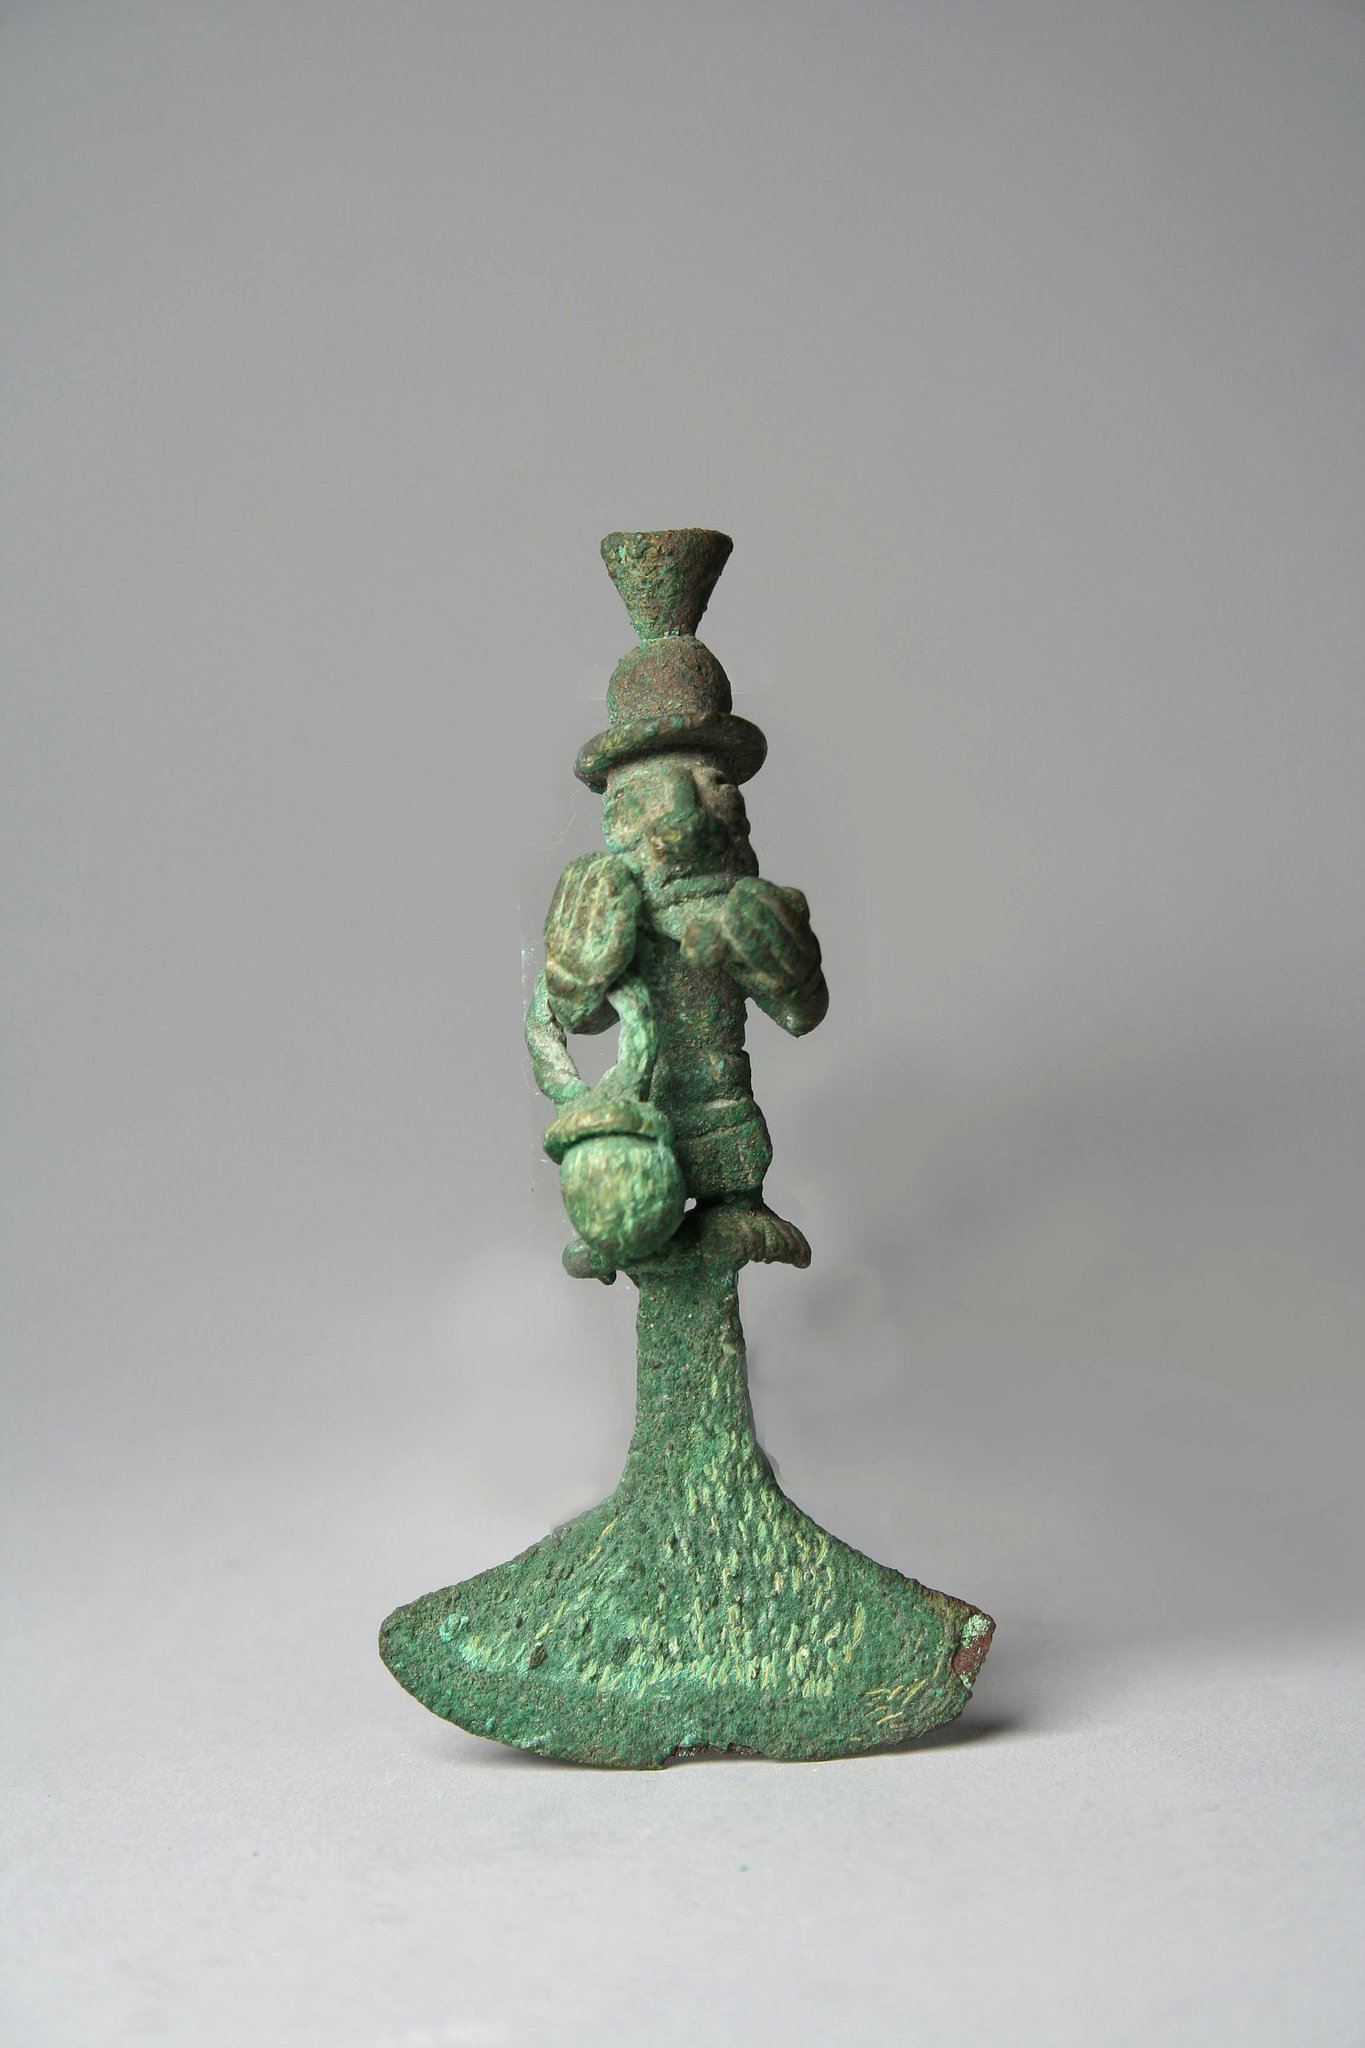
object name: knife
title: Ceremonial Knife (Tumi)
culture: moche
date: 201-700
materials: copper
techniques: casting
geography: peru